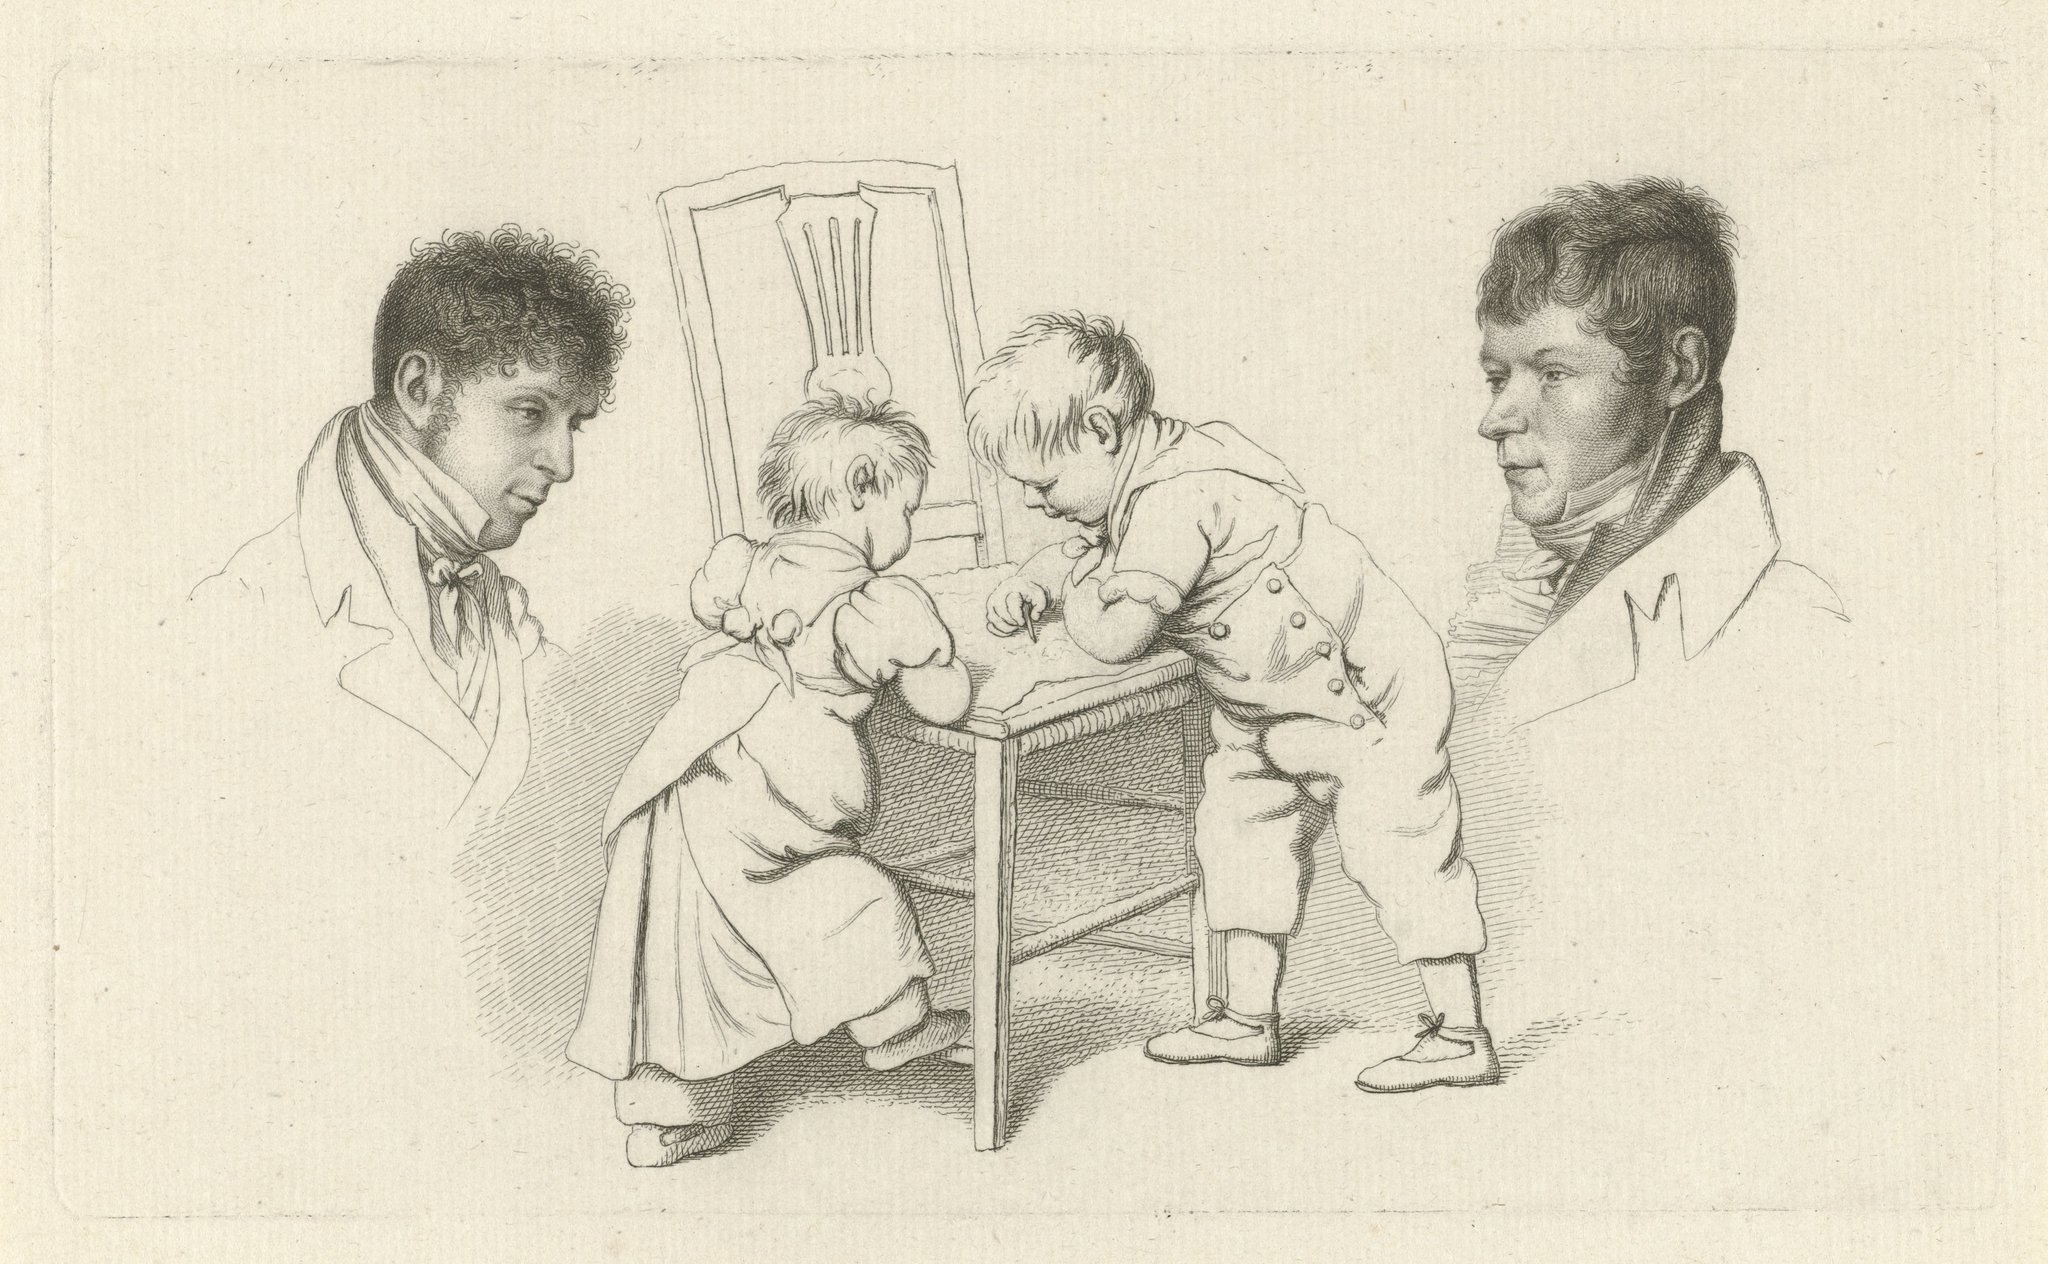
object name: print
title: Portretten van Abraham Lion Zeelander en Anthony Oberman en twee tekenende kinderen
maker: jacob ernst marcus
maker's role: draughtsman, print maker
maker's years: 1774-1826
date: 1812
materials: paper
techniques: etching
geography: amsterdam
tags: anthony oberman, abraham lion zeelander, drawing, children's games and plays, chair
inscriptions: collector's mark: Lugt 2228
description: Bustes van de kunstenaars Abraham Lion Zeelander en Anthony Oberman aan weerszijden van een afbeelding van twee tekenende kinderen bij een stoel.